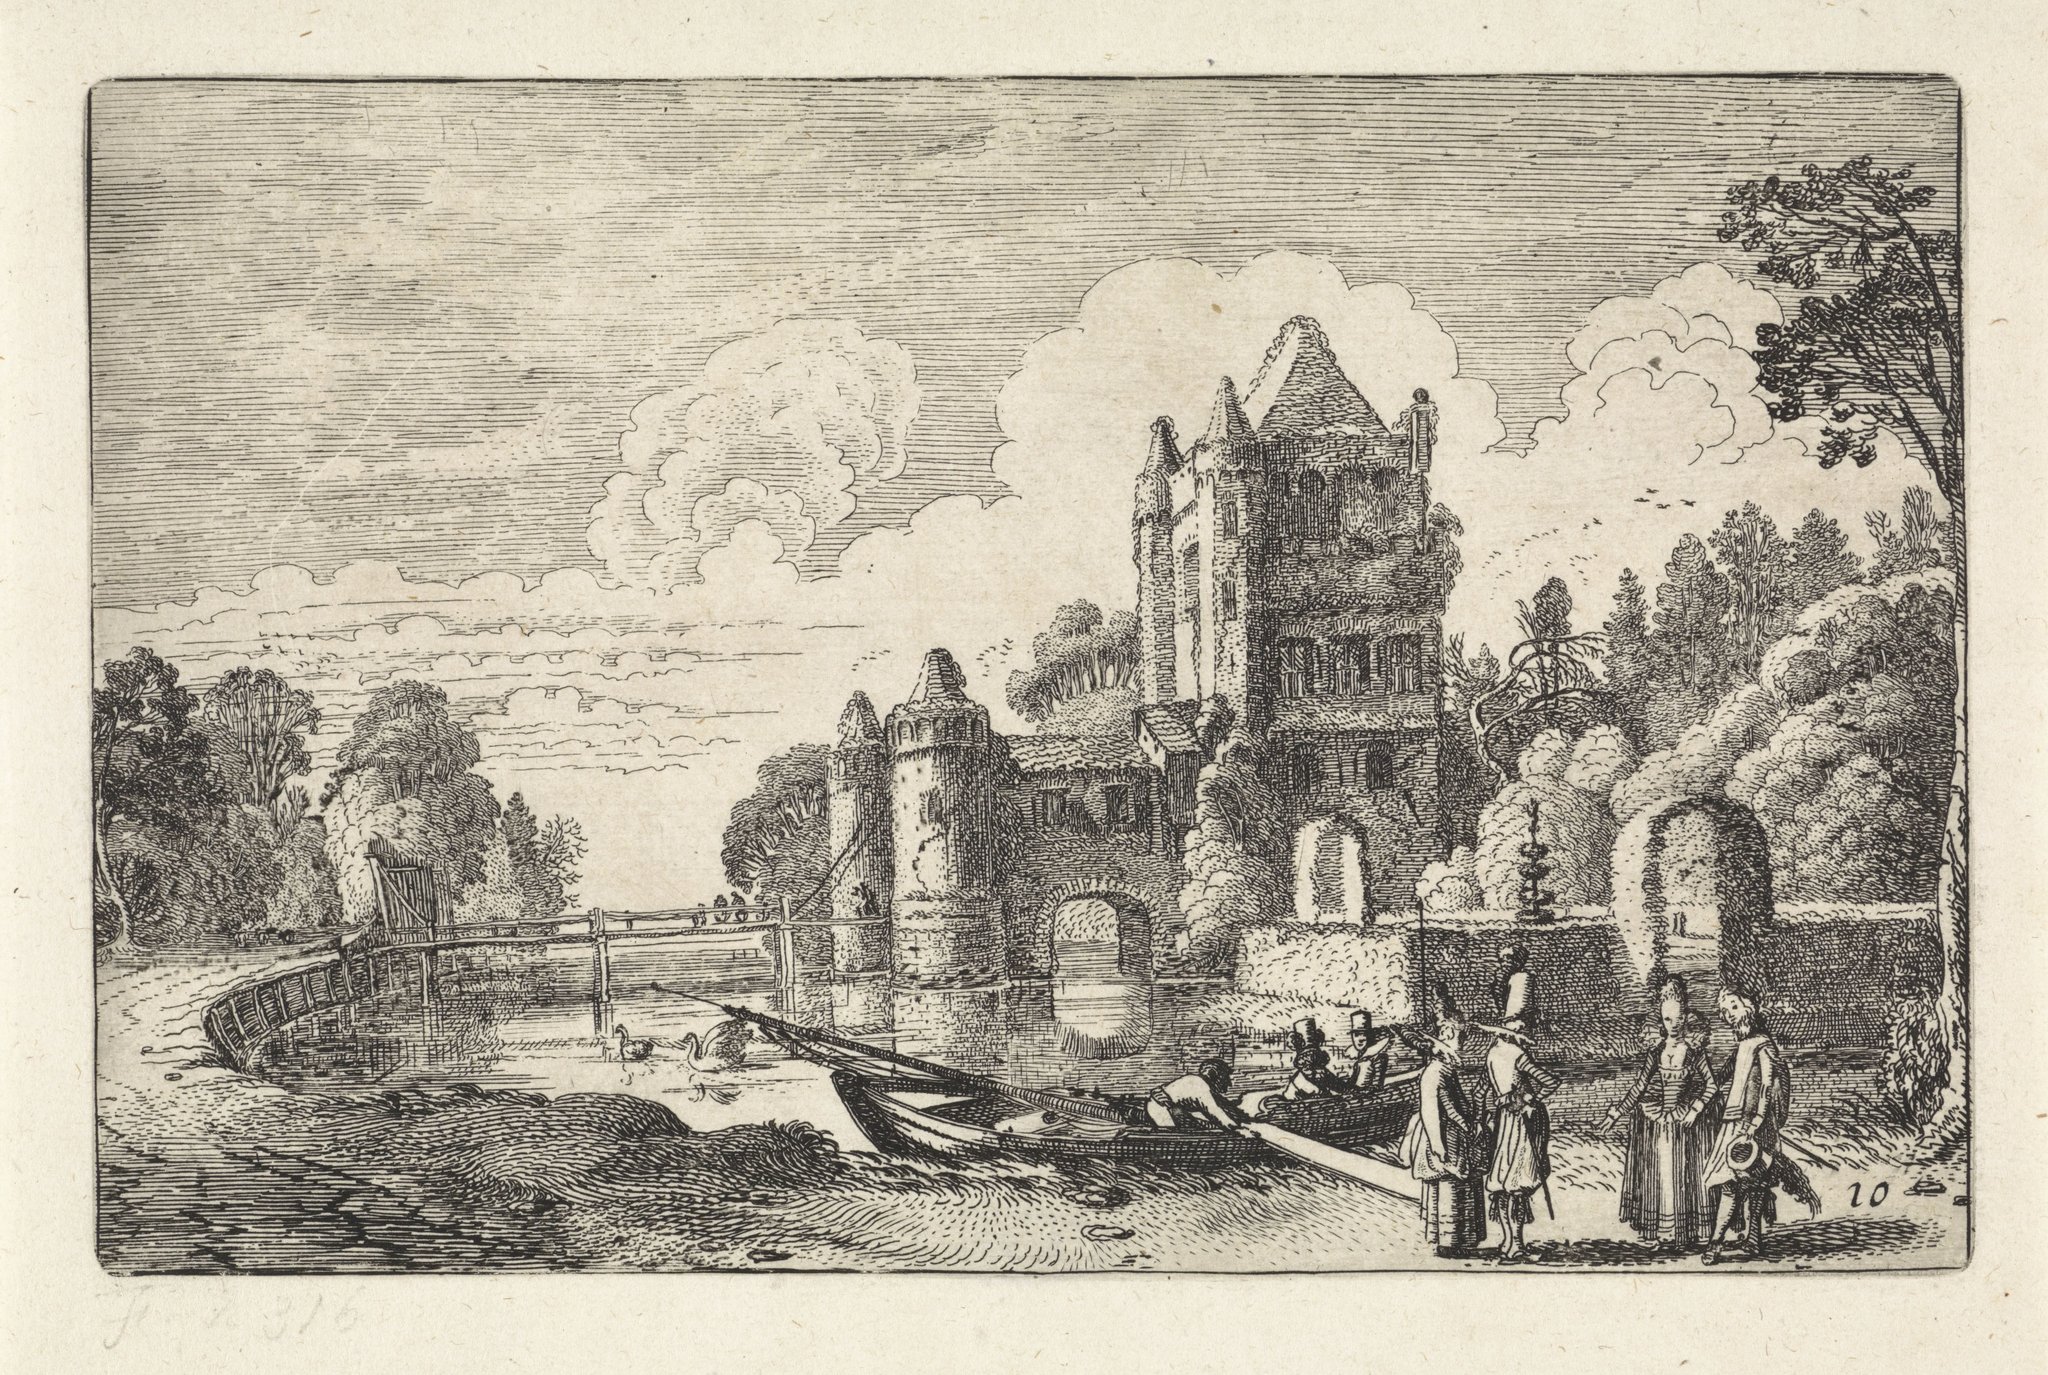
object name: print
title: Landschappen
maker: jan van de velde (ii)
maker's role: draughtsman, painter, print maker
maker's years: 1593-1641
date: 1616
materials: paper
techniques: etching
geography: northern netherlands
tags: passengers ~ ship (+ preparations ~ departure), landscape with tower or castle, city-gate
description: Landschap met de Amsterdamse Poort te Haarlem. Op de voorgrond een elegant gezelschap bij een boot met een loopplank op de oever. Tiende prent van deel vier van een serie van in totaal zestig prenten met landschappen, verdeeld over vijf delen van elk twaalf prenten.